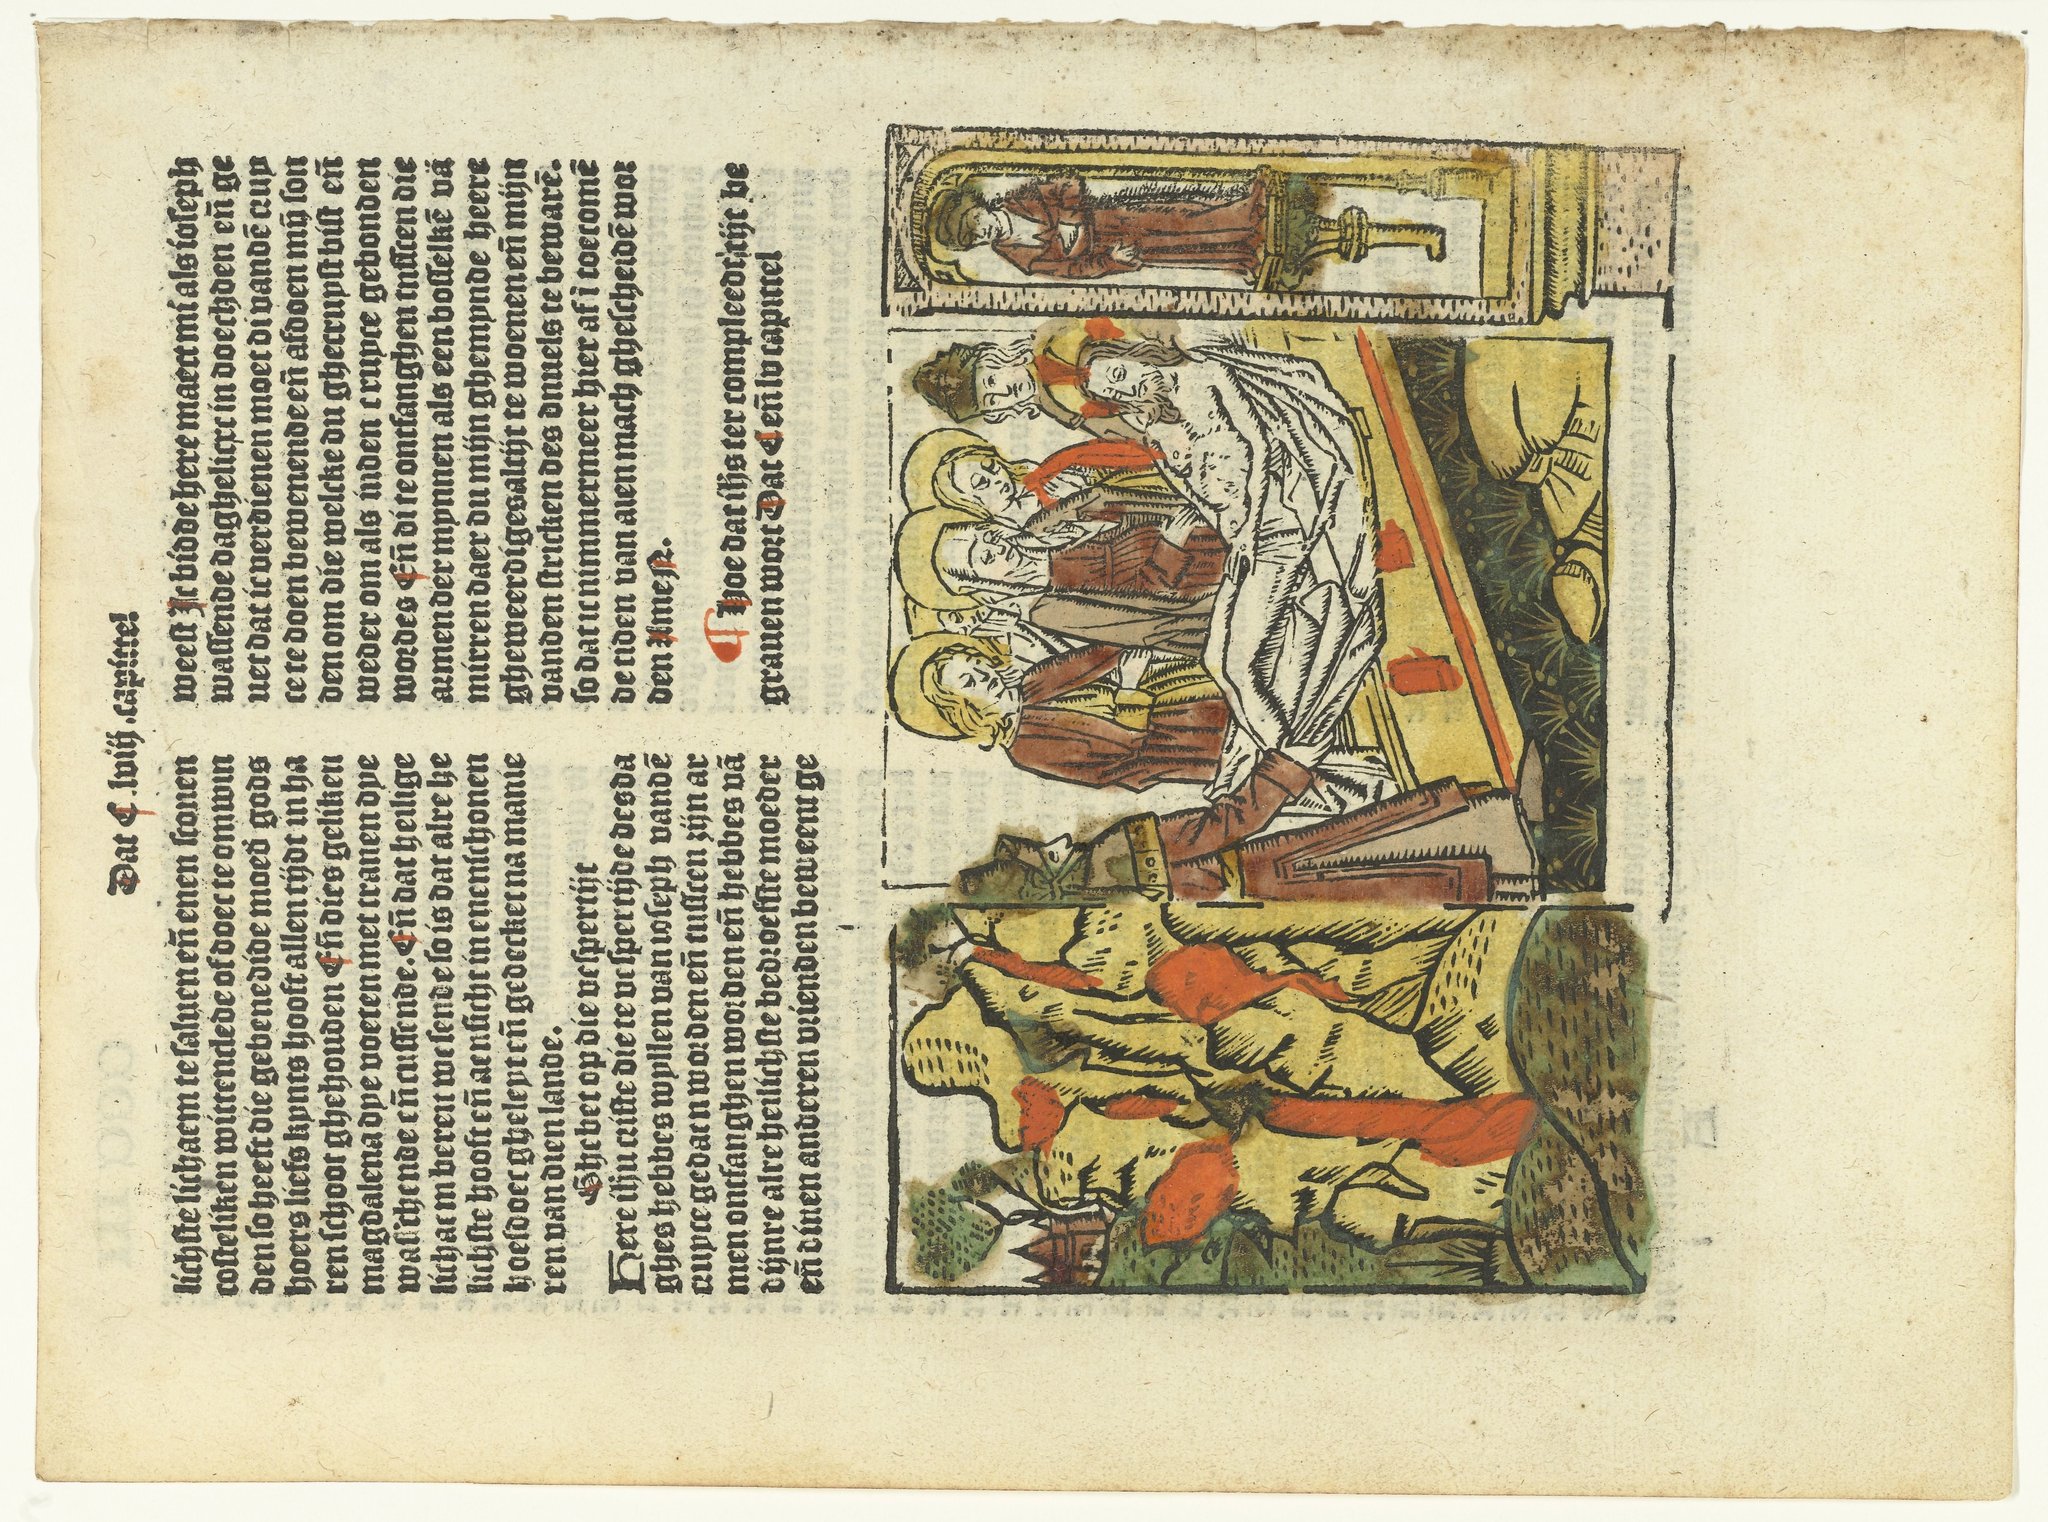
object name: print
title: Graflegging van Christus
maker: Anonymous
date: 1480-1500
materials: paper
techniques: hand coloring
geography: low countries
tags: christ's entombment (possibly by angels)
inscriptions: collector's mark: Lugt 2228a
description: Blad uit een boek, bovenste helft gedrukte tekst, daaronder drie voorstellingen gedrukt van drie blokken. In het midden graflegging van Christus, links daarvan een landschap, rechts een standbeeld in een nis.